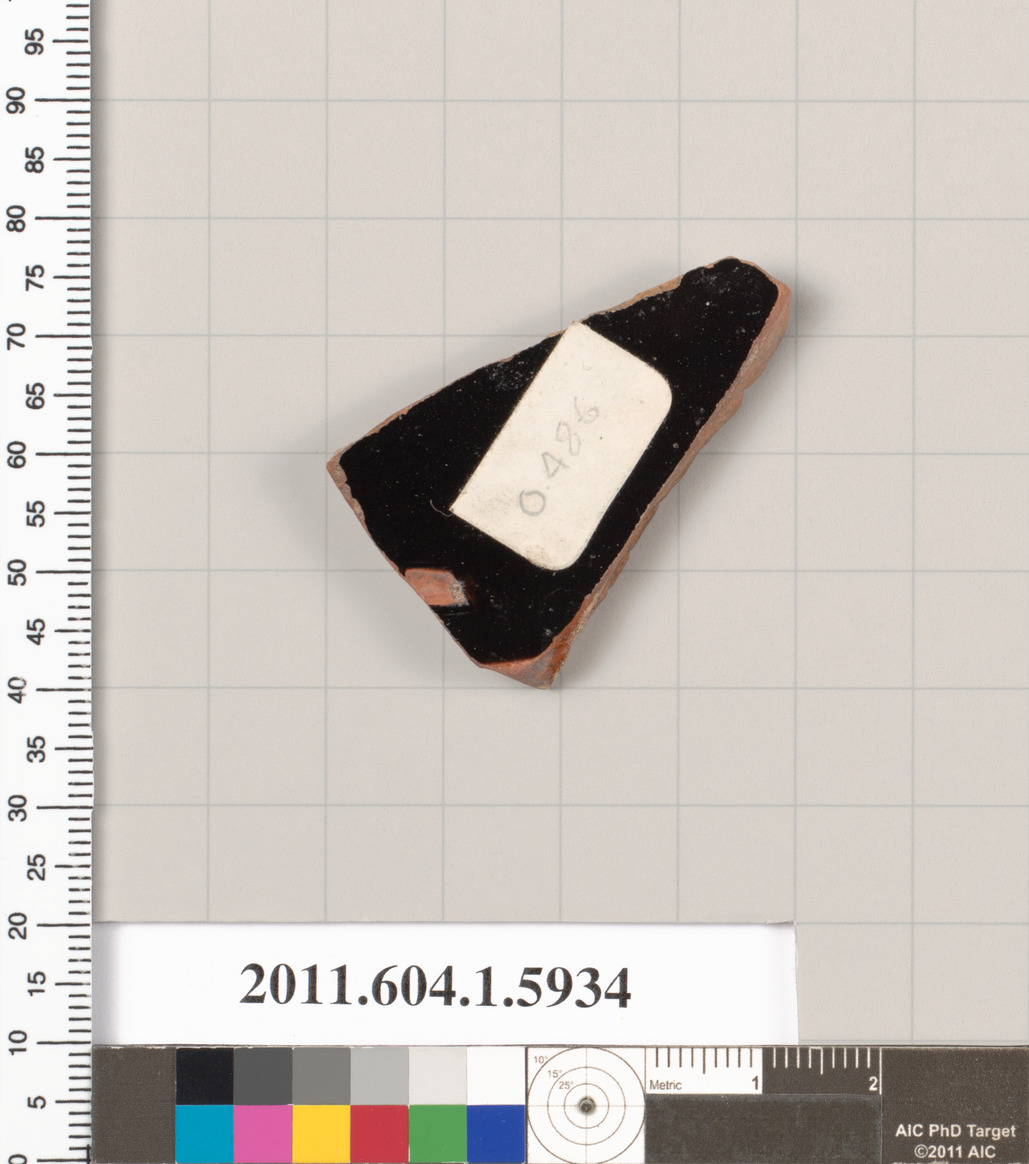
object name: kylix fragment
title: Terracotta fragment of a kylix (drinking cup)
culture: greek, attic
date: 520-510 BCE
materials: terracotta